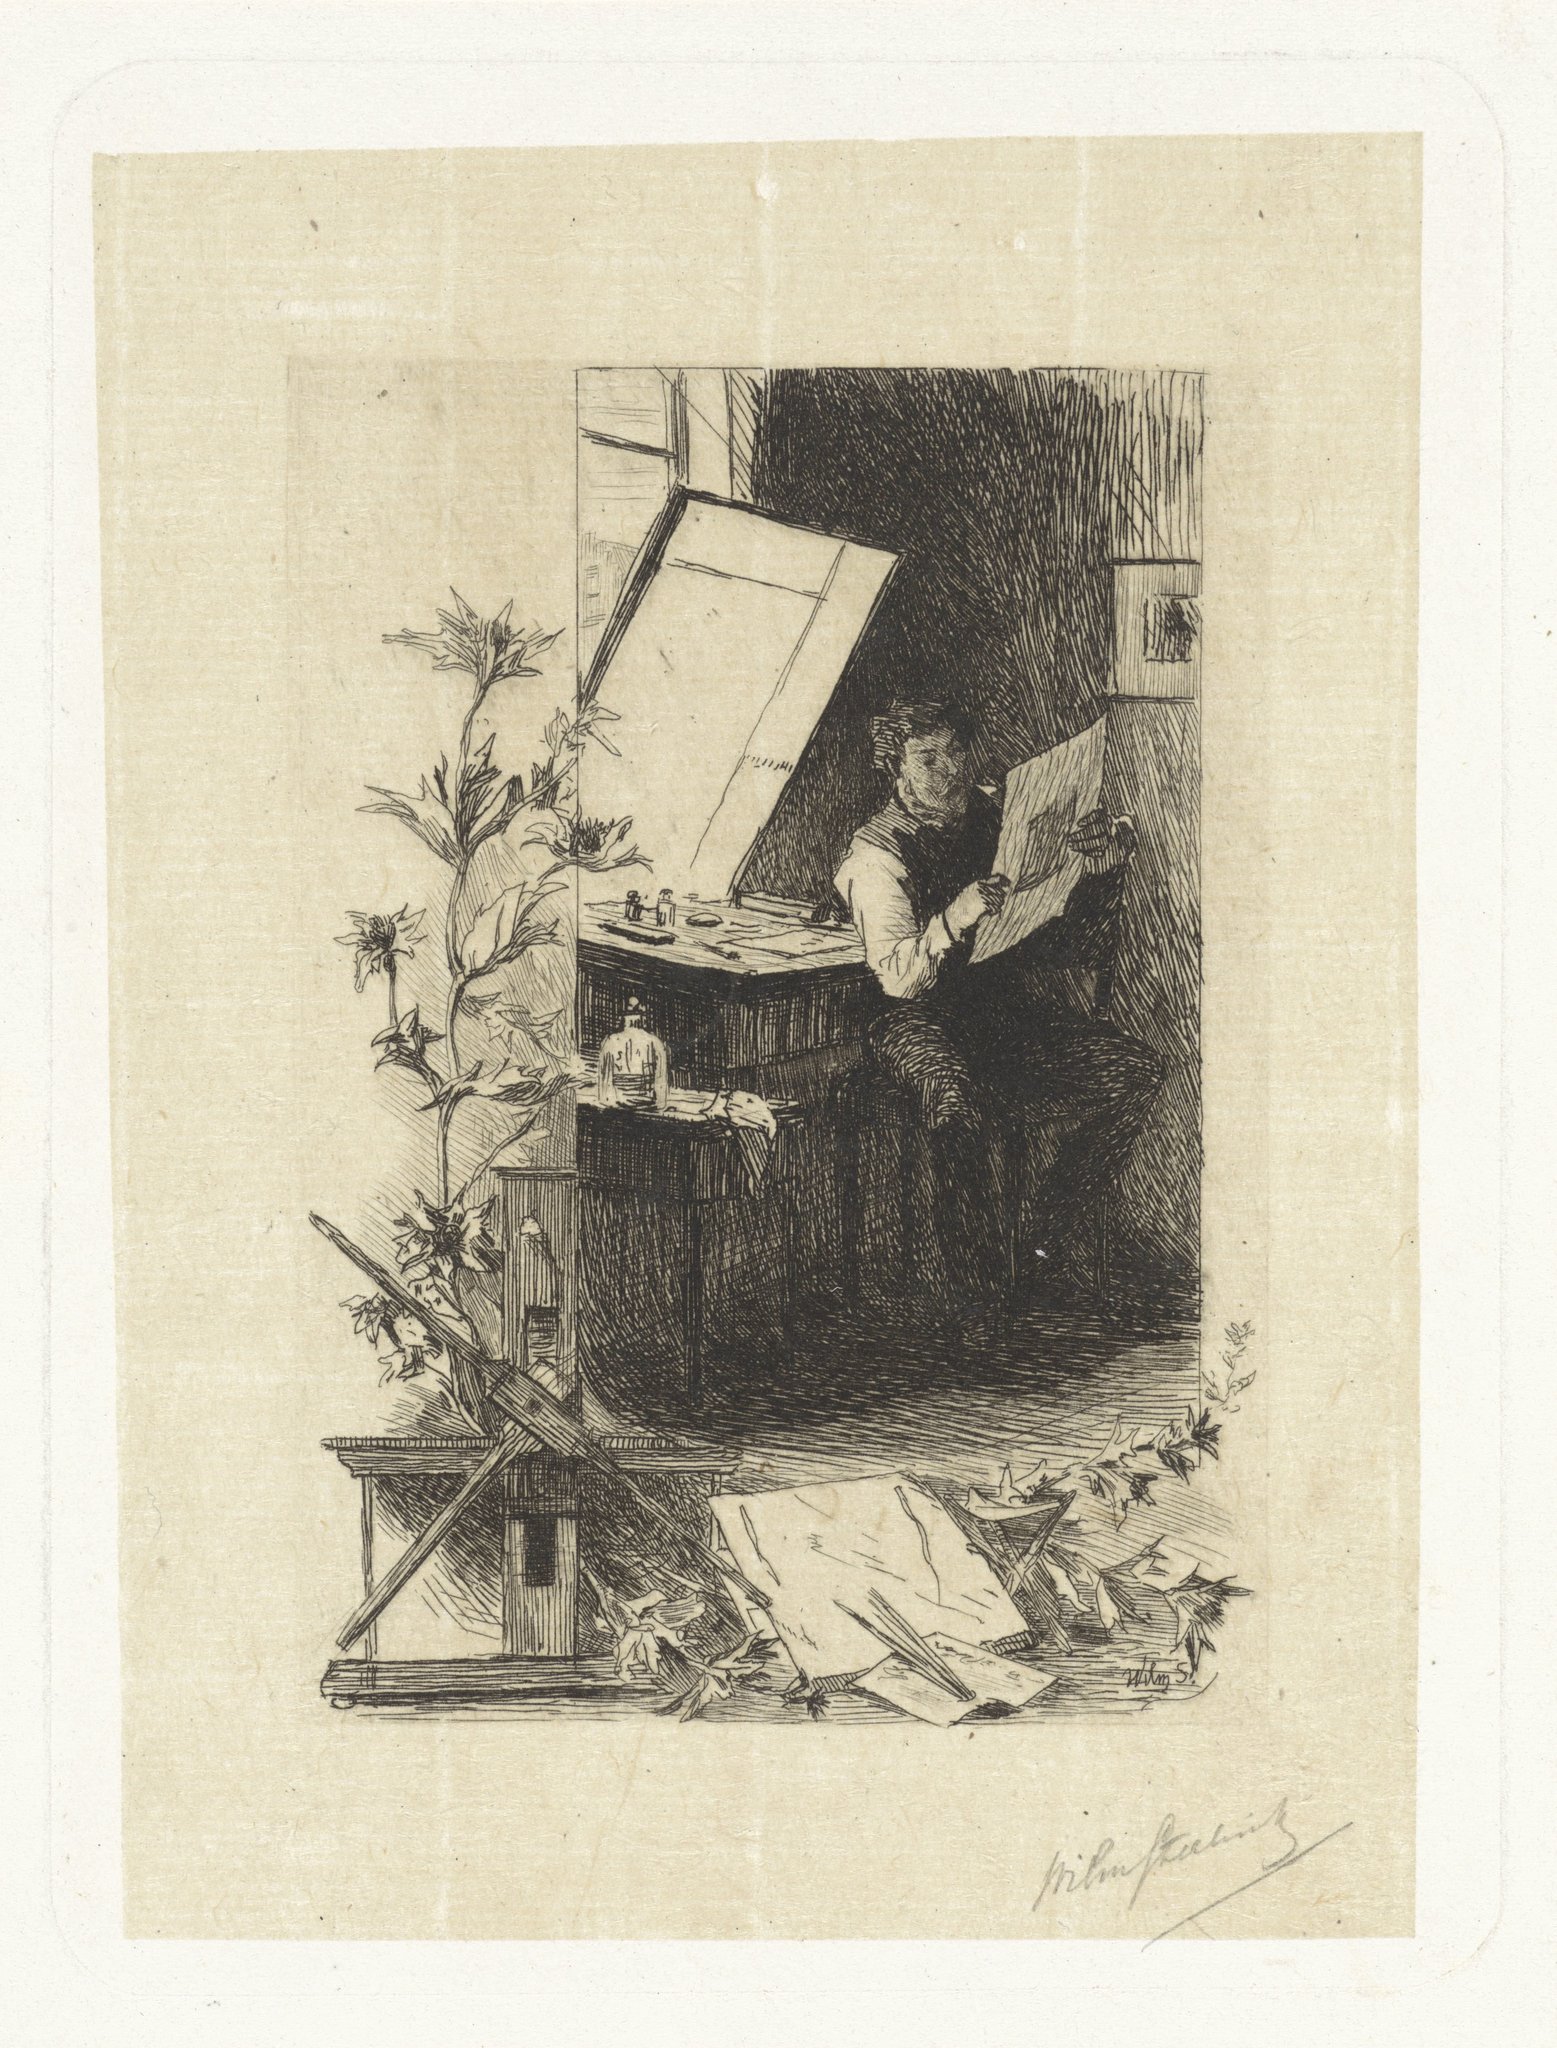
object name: print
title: Prentmaker in zijn atelier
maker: willem steelink (ii)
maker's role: draughtsman, print maker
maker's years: 1856-1928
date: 1866-1886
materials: paper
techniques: etching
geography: netherlands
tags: printing press, graphic artist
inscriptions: collector's mark: Lugt 2228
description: Een prentmaker bekijkt een prent bij het licht van een open raam. Op de voorgrond een drukpers en een distel.